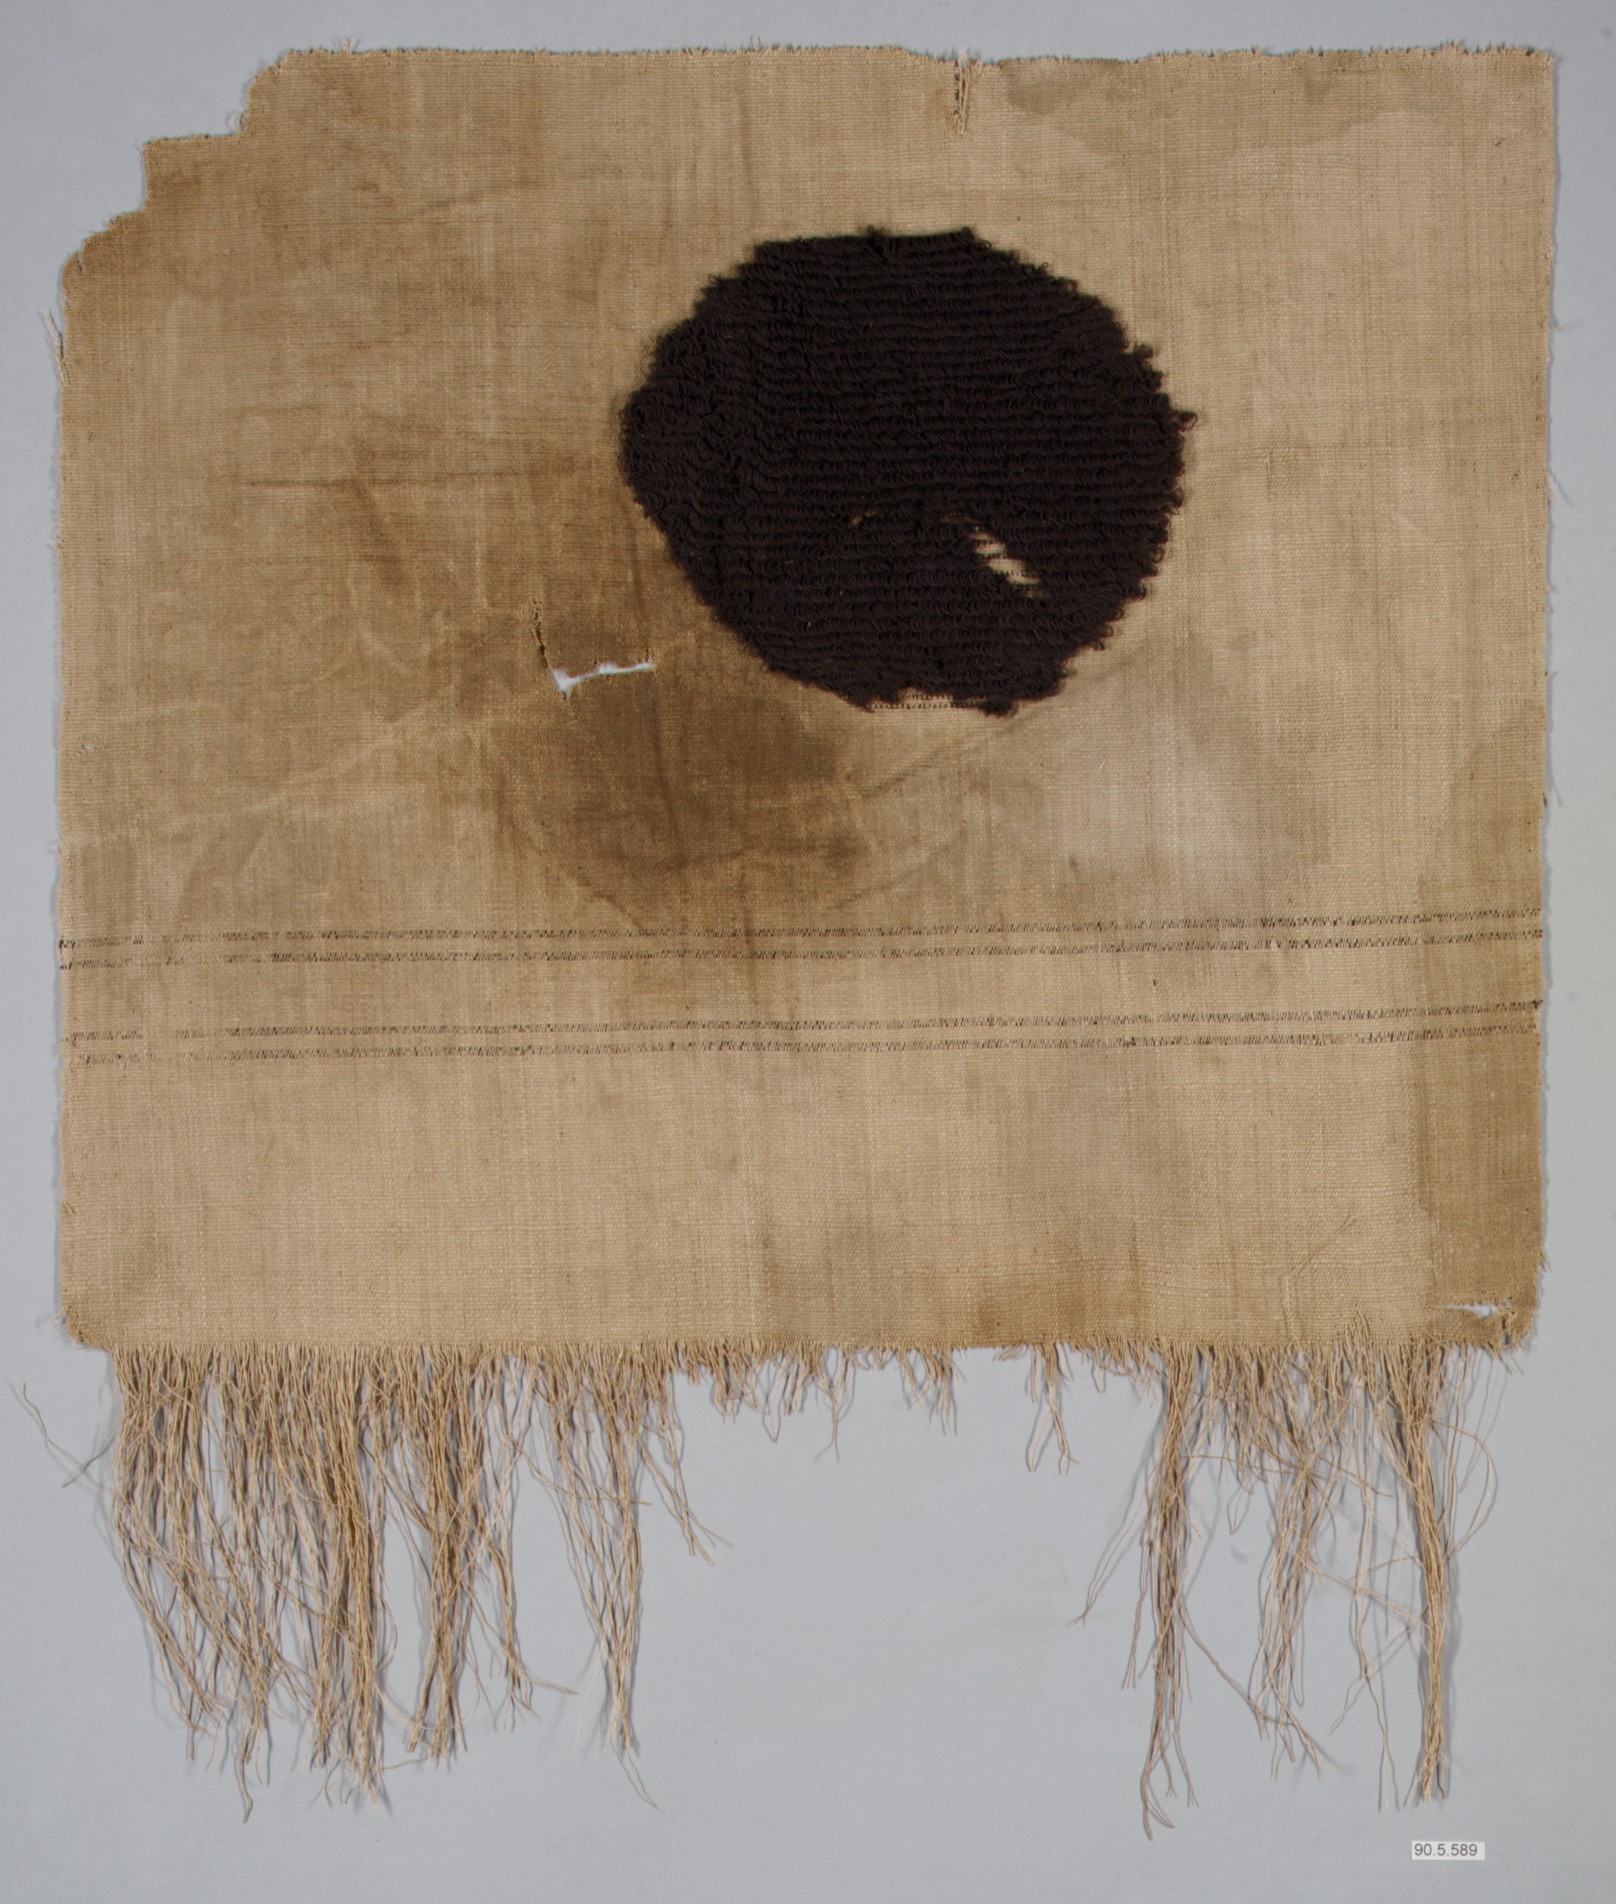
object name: textile fragment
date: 201-300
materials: linen, wool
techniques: weave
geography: egypt